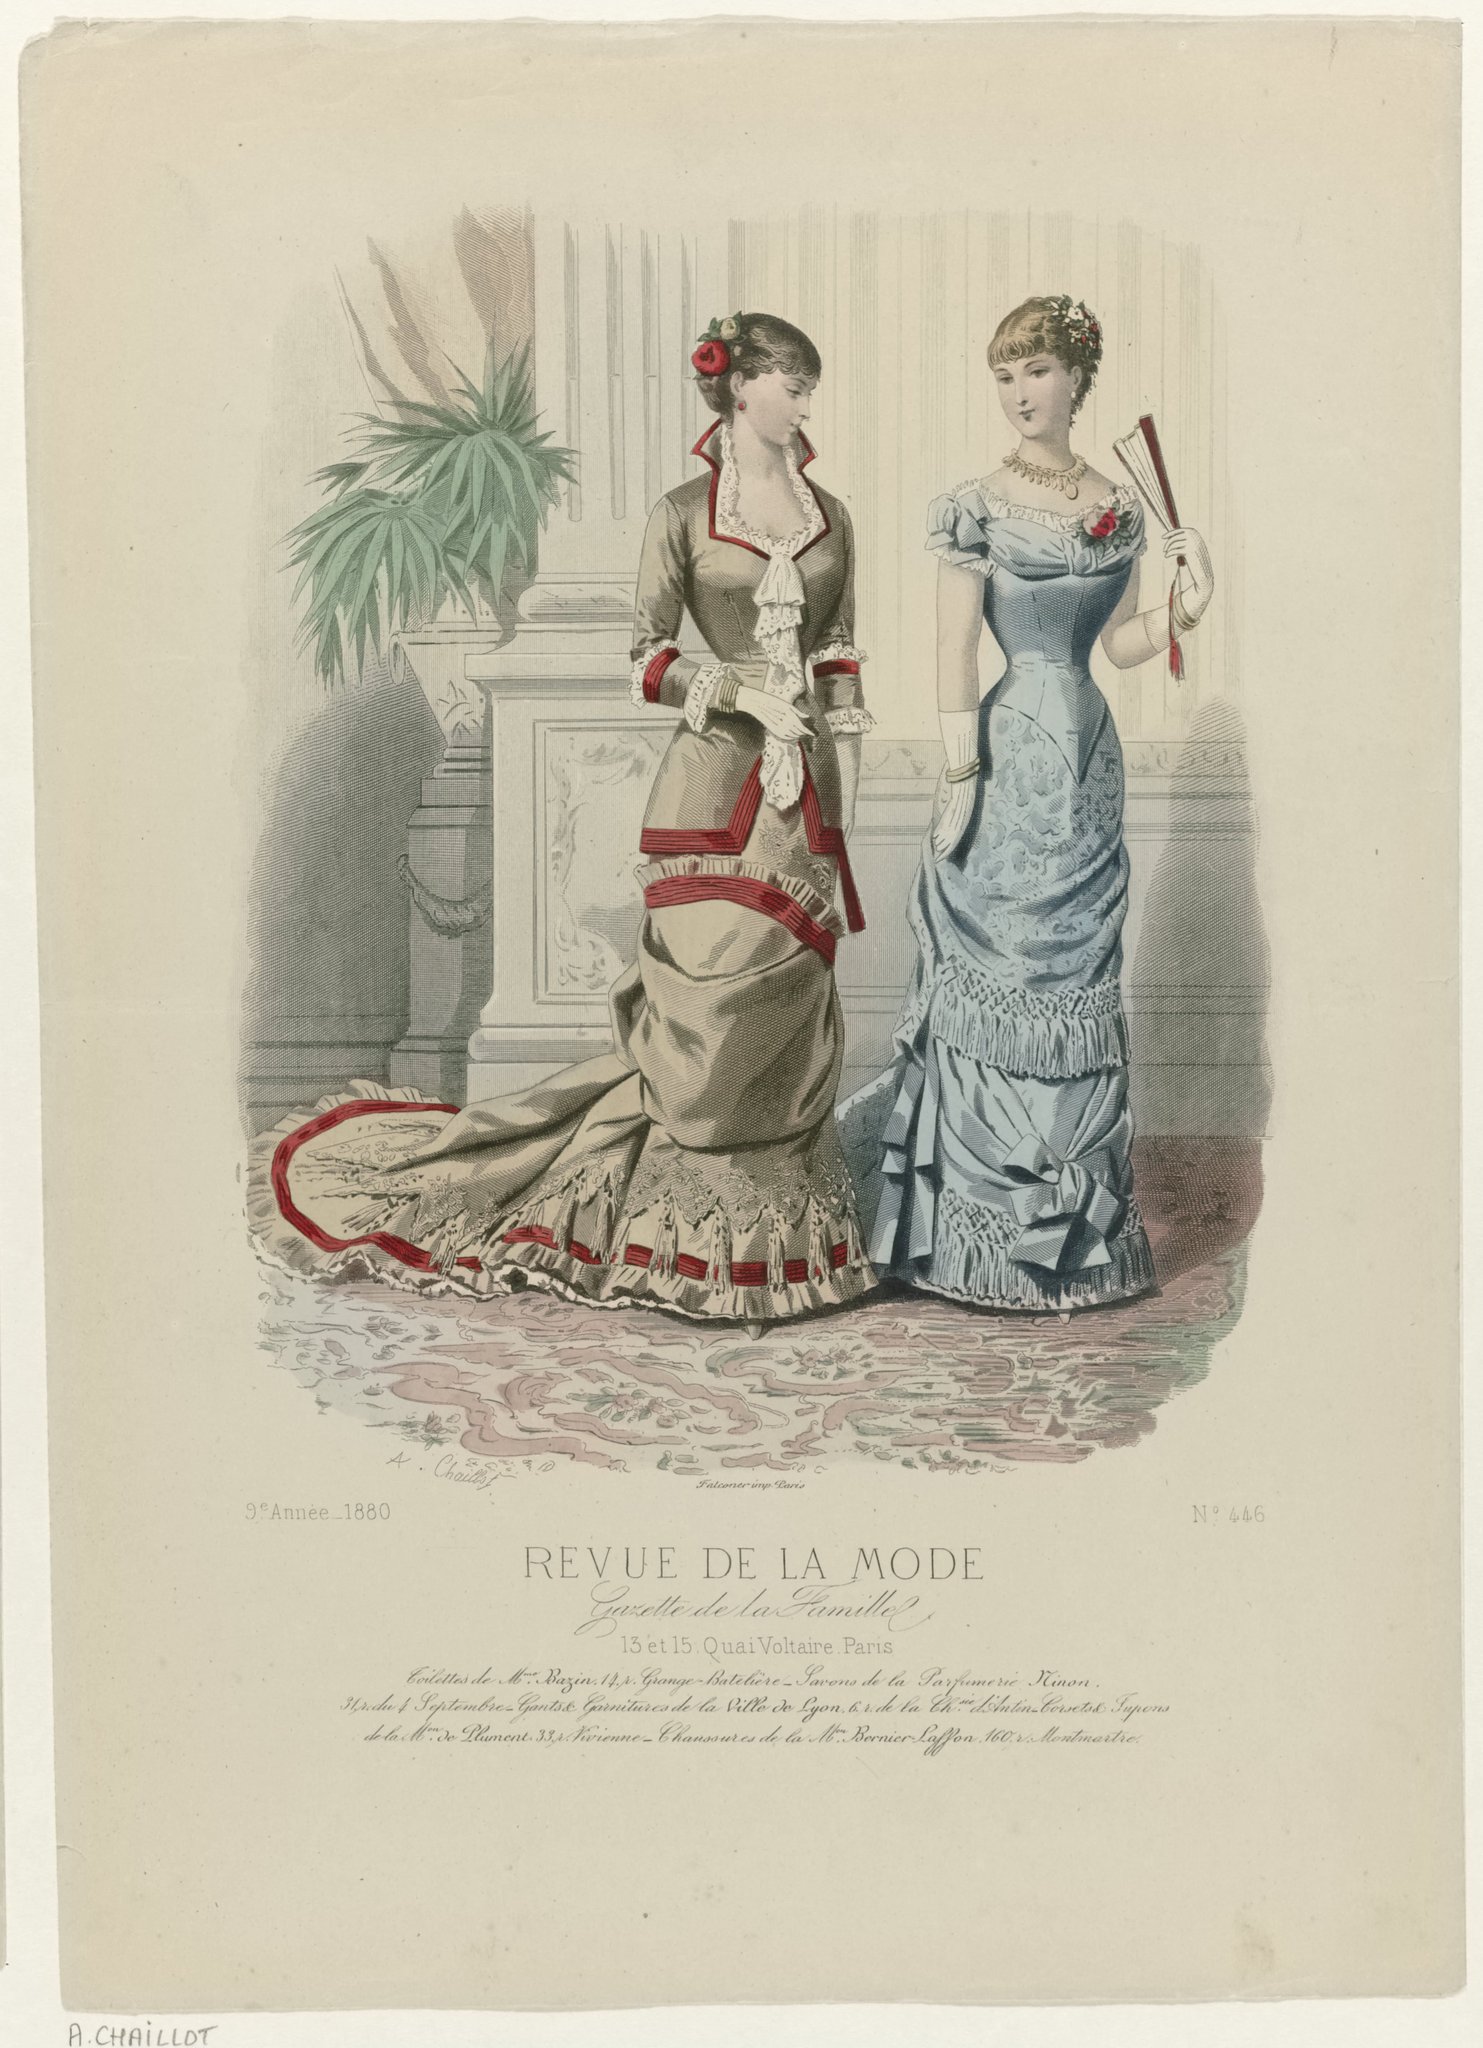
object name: fashion print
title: Revue de la Mode, Gazette de la Famille, dimanche 18 juillet 1880, 9e année, No. 446: Toilettes de Mme Bazin (...)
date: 1880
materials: paper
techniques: engraving, hand coloring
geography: paris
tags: corsage (+ women's clothes), flowers, dress, gown: evening dress (+ women's clothes), gloves, mittens (long gloves) (+ women's clothes), clothing for the upper part of the body (shawl) (+ women's clothes), dress, gown: ball gown (+ women's clothes), border, ribbon, braid (+ women's clothes), dress, gown: dinner dress (+ women's clothes), fashion plates, fan (+ women's clothes), bracelet, wristlet (+ women's clothes), necklace (+ women's clothes)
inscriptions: address: ‘13 et 15, Quai Voltaire, Paris’, caption: ‘Toilettes de Mme Bazin, 14, r. Grange-Batelière_Savons de la Parfumerie Ninon. 31. r. du 4 Septembre_Gants & Garnitures de la Ville de Lyon, 6, r. de la Ch.sée d'Antin_Corsets & Jupons de la M.on de Plument, 33, r, Vivienne_Chaussures de la M.on Bernier-Laffon, 160, r. Montmartre.’, title: ‘REVUE DE LA MODE / Gazette de la Famille’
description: Twee vrouwen in een interieur, in japonnen van Bazin. Links: zomerjapon "nuance tourterelle' gegarneerd met rood satijn, voor diners en soirees Rechts: blauwe japon voor bals en soirees in het casino: rok met sleep van zijde afgezet met ruche, waarover een grote sjaal afgezet met franjes. Onder de afbeelding enkele regels reclametekst voor verschillende producten. Prent uit het modetijdschrift Revue de la Mode (1872-1913). Uitgebreide beschrijving van de kleding op pagina 243 en 245 "PLANCHE COLORIÉE".